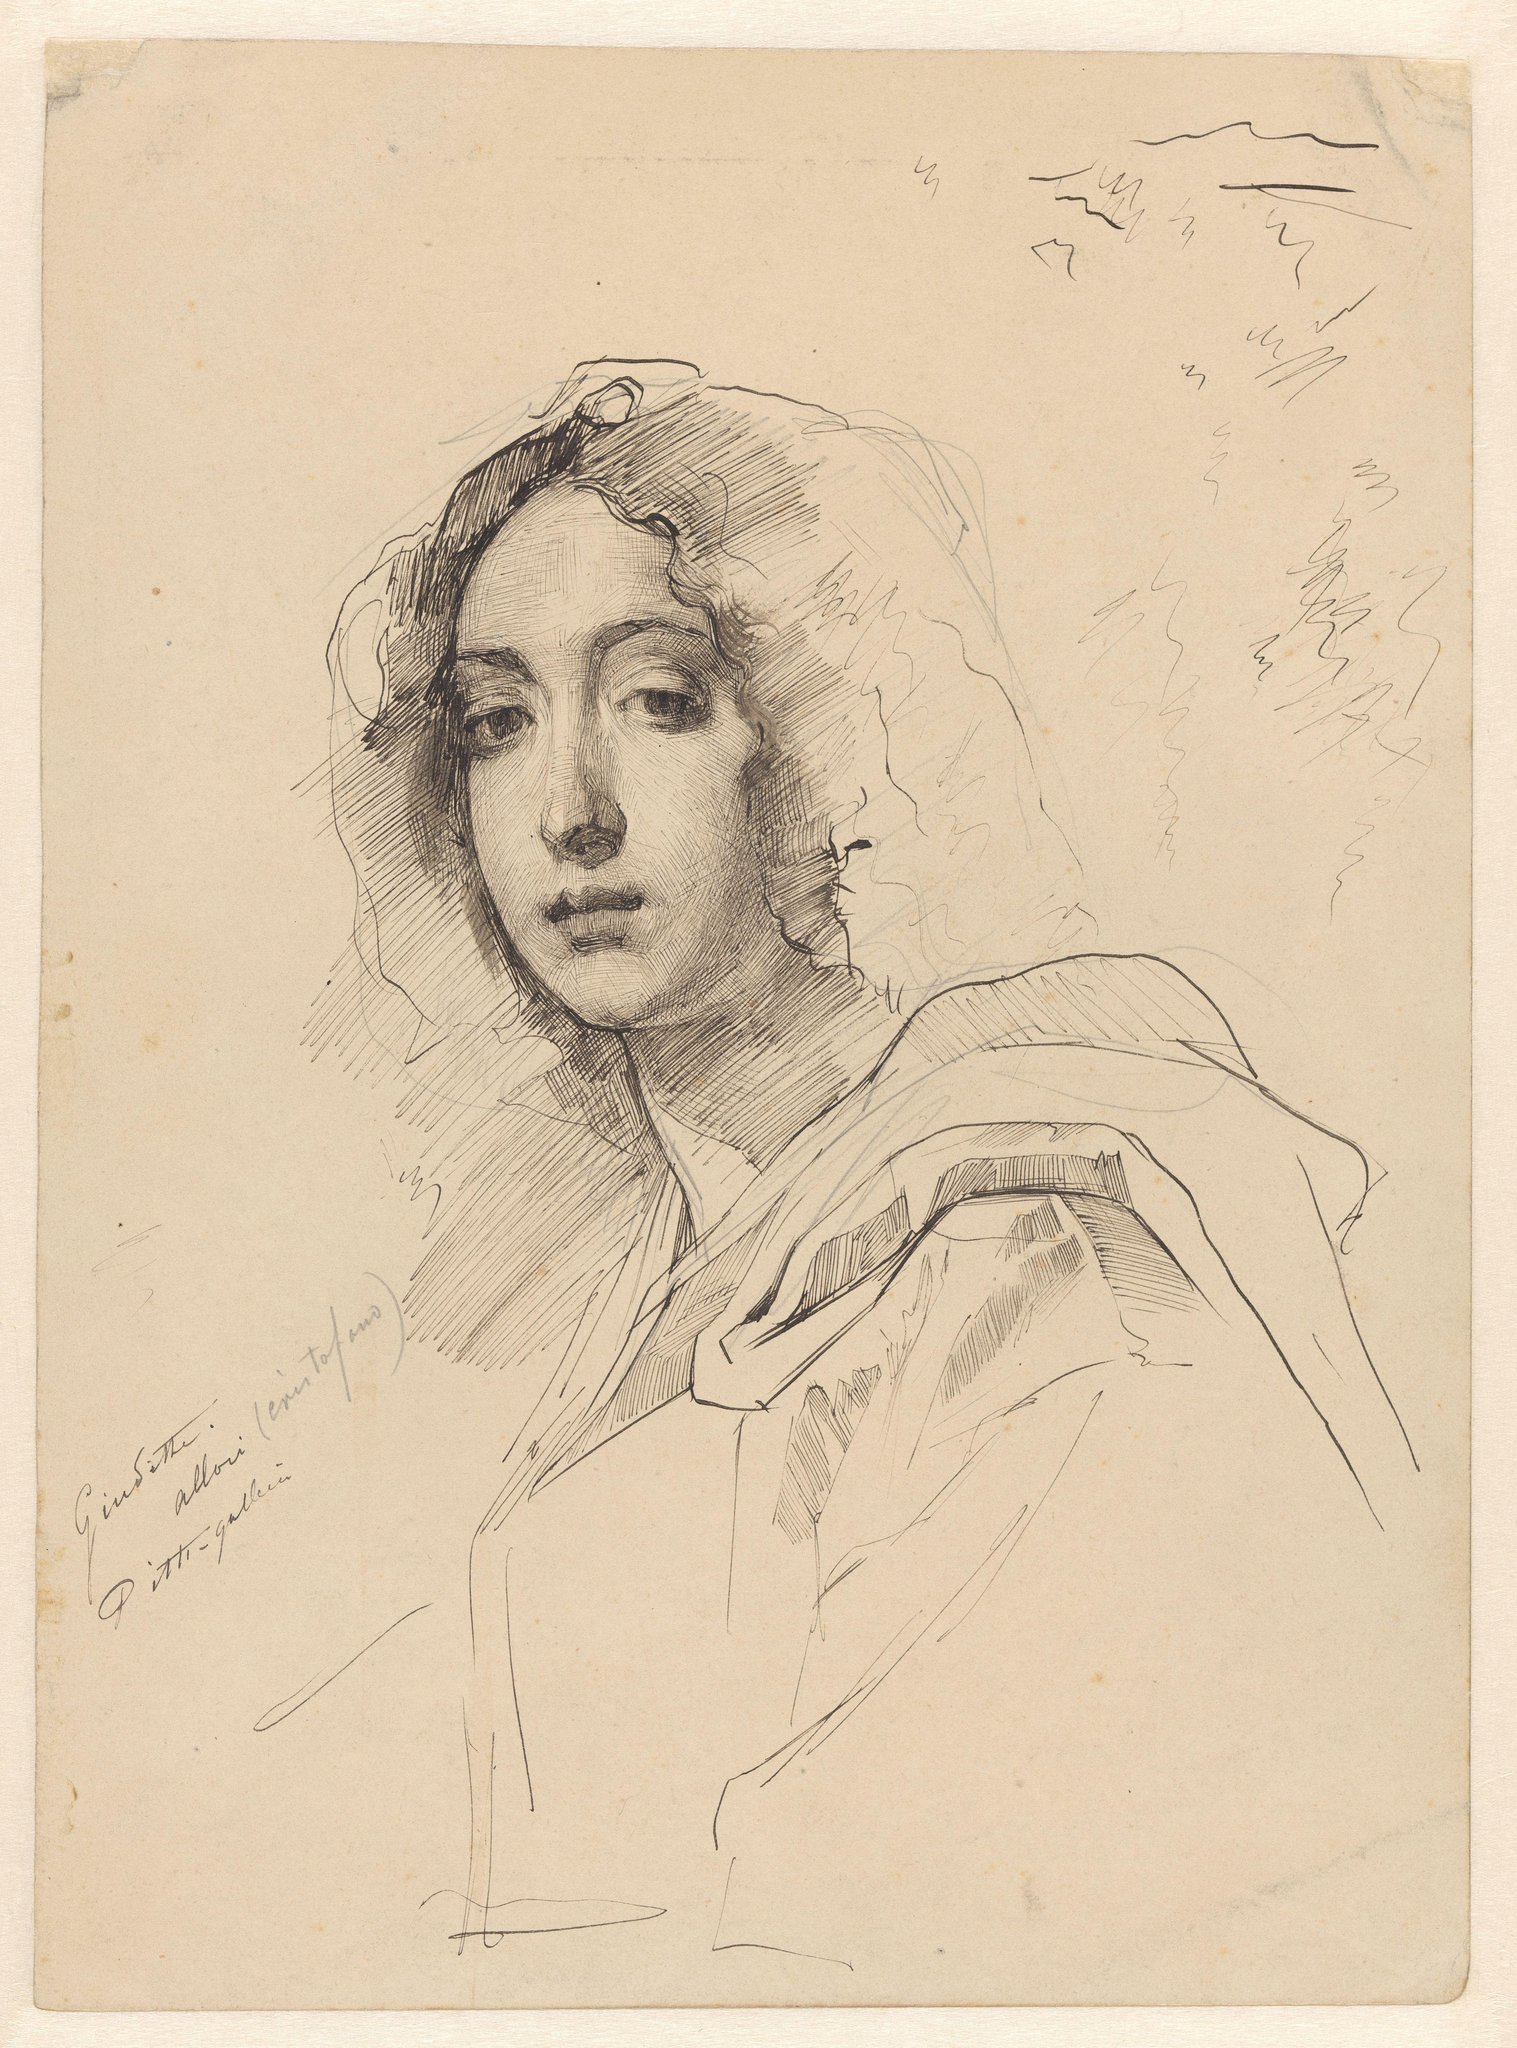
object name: drawing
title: Judith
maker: nicolaas van der waay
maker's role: draughtsman, painter, print maker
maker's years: 1855-1936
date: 1884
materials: ink, paper, pencil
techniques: pen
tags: the book of judith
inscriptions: collector's mark: Lugt 2760, annotation: ‘Giuditte./ allori (cristofano)/ Pitti-galerie.’, collector's mark: Lugt 2228, annotation: ‘[...]J/ 109/30’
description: Getekend naar een detail uit het schilderij van Judith met het hoofd van Holofernes.